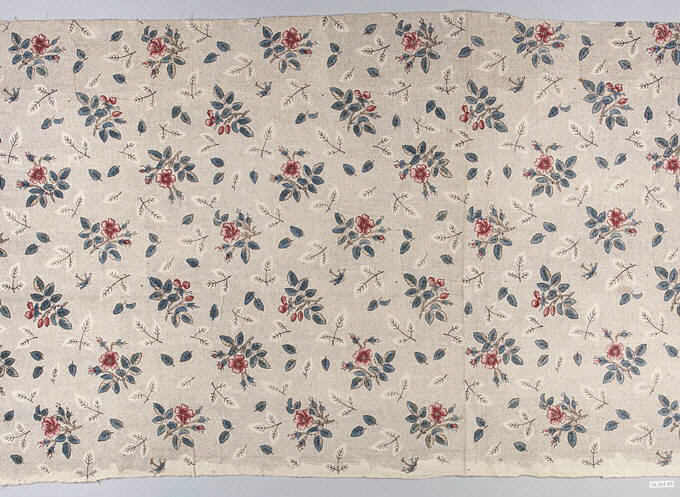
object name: floral print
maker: oberkampf manufactory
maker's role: manufactory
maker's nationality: french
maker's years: 1760-1843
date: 1770-1775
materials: linen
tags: flowers